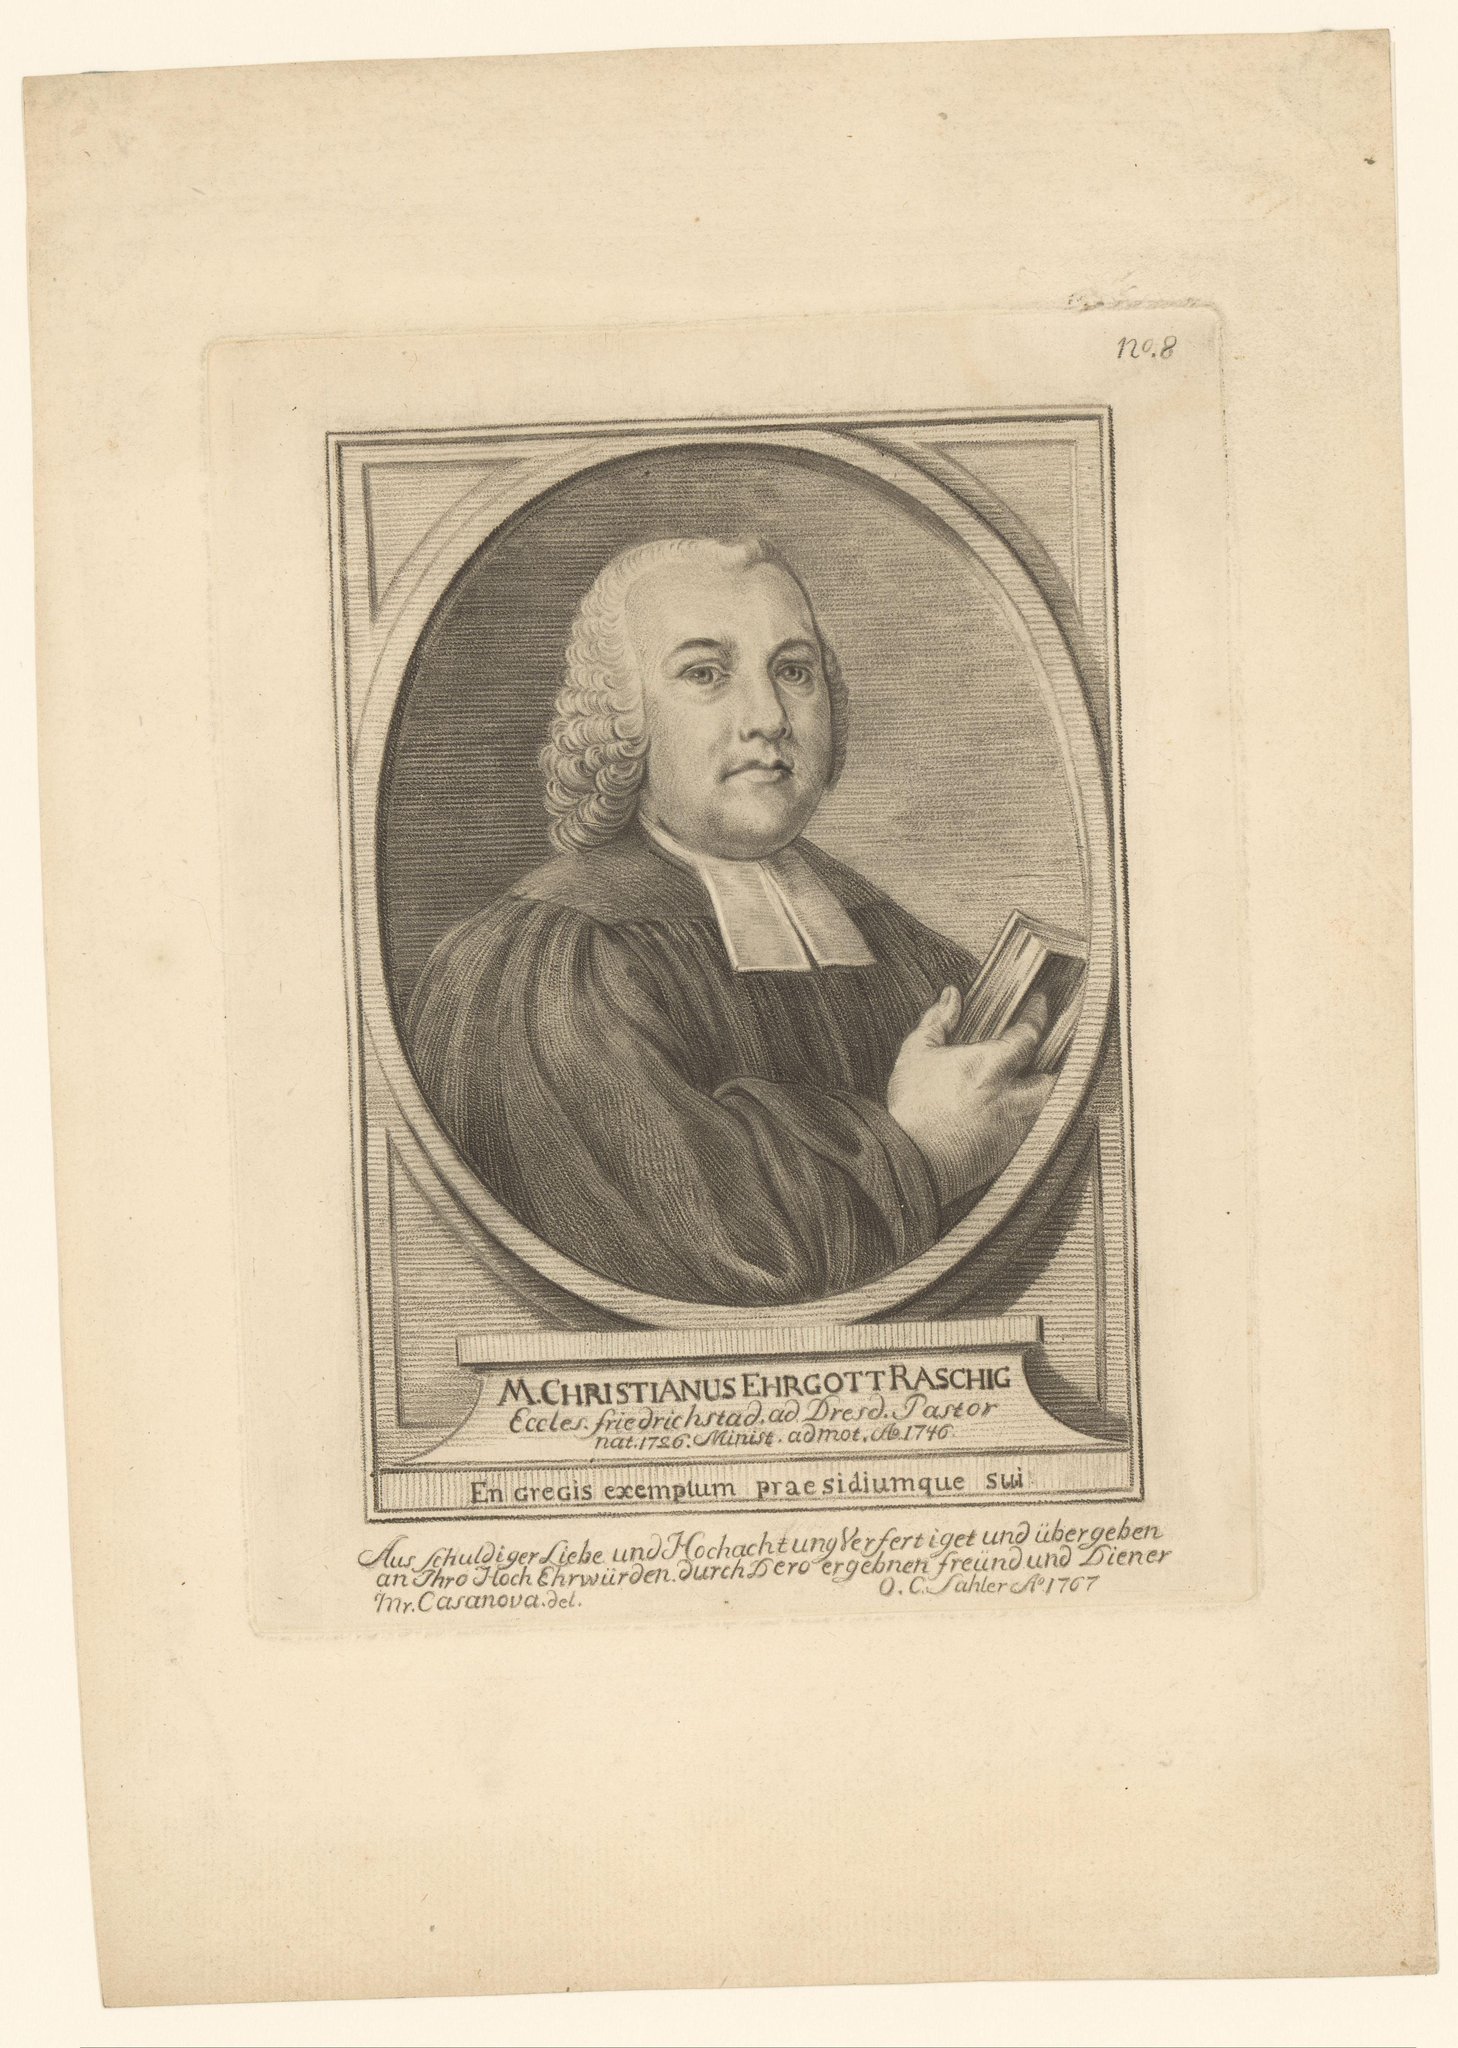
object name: print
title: Portret van Christian Ehregott Raschig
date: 1767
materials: paper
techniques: printmaking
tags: theologian, historical persons, book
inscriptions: collector's mark: Lugt 2228